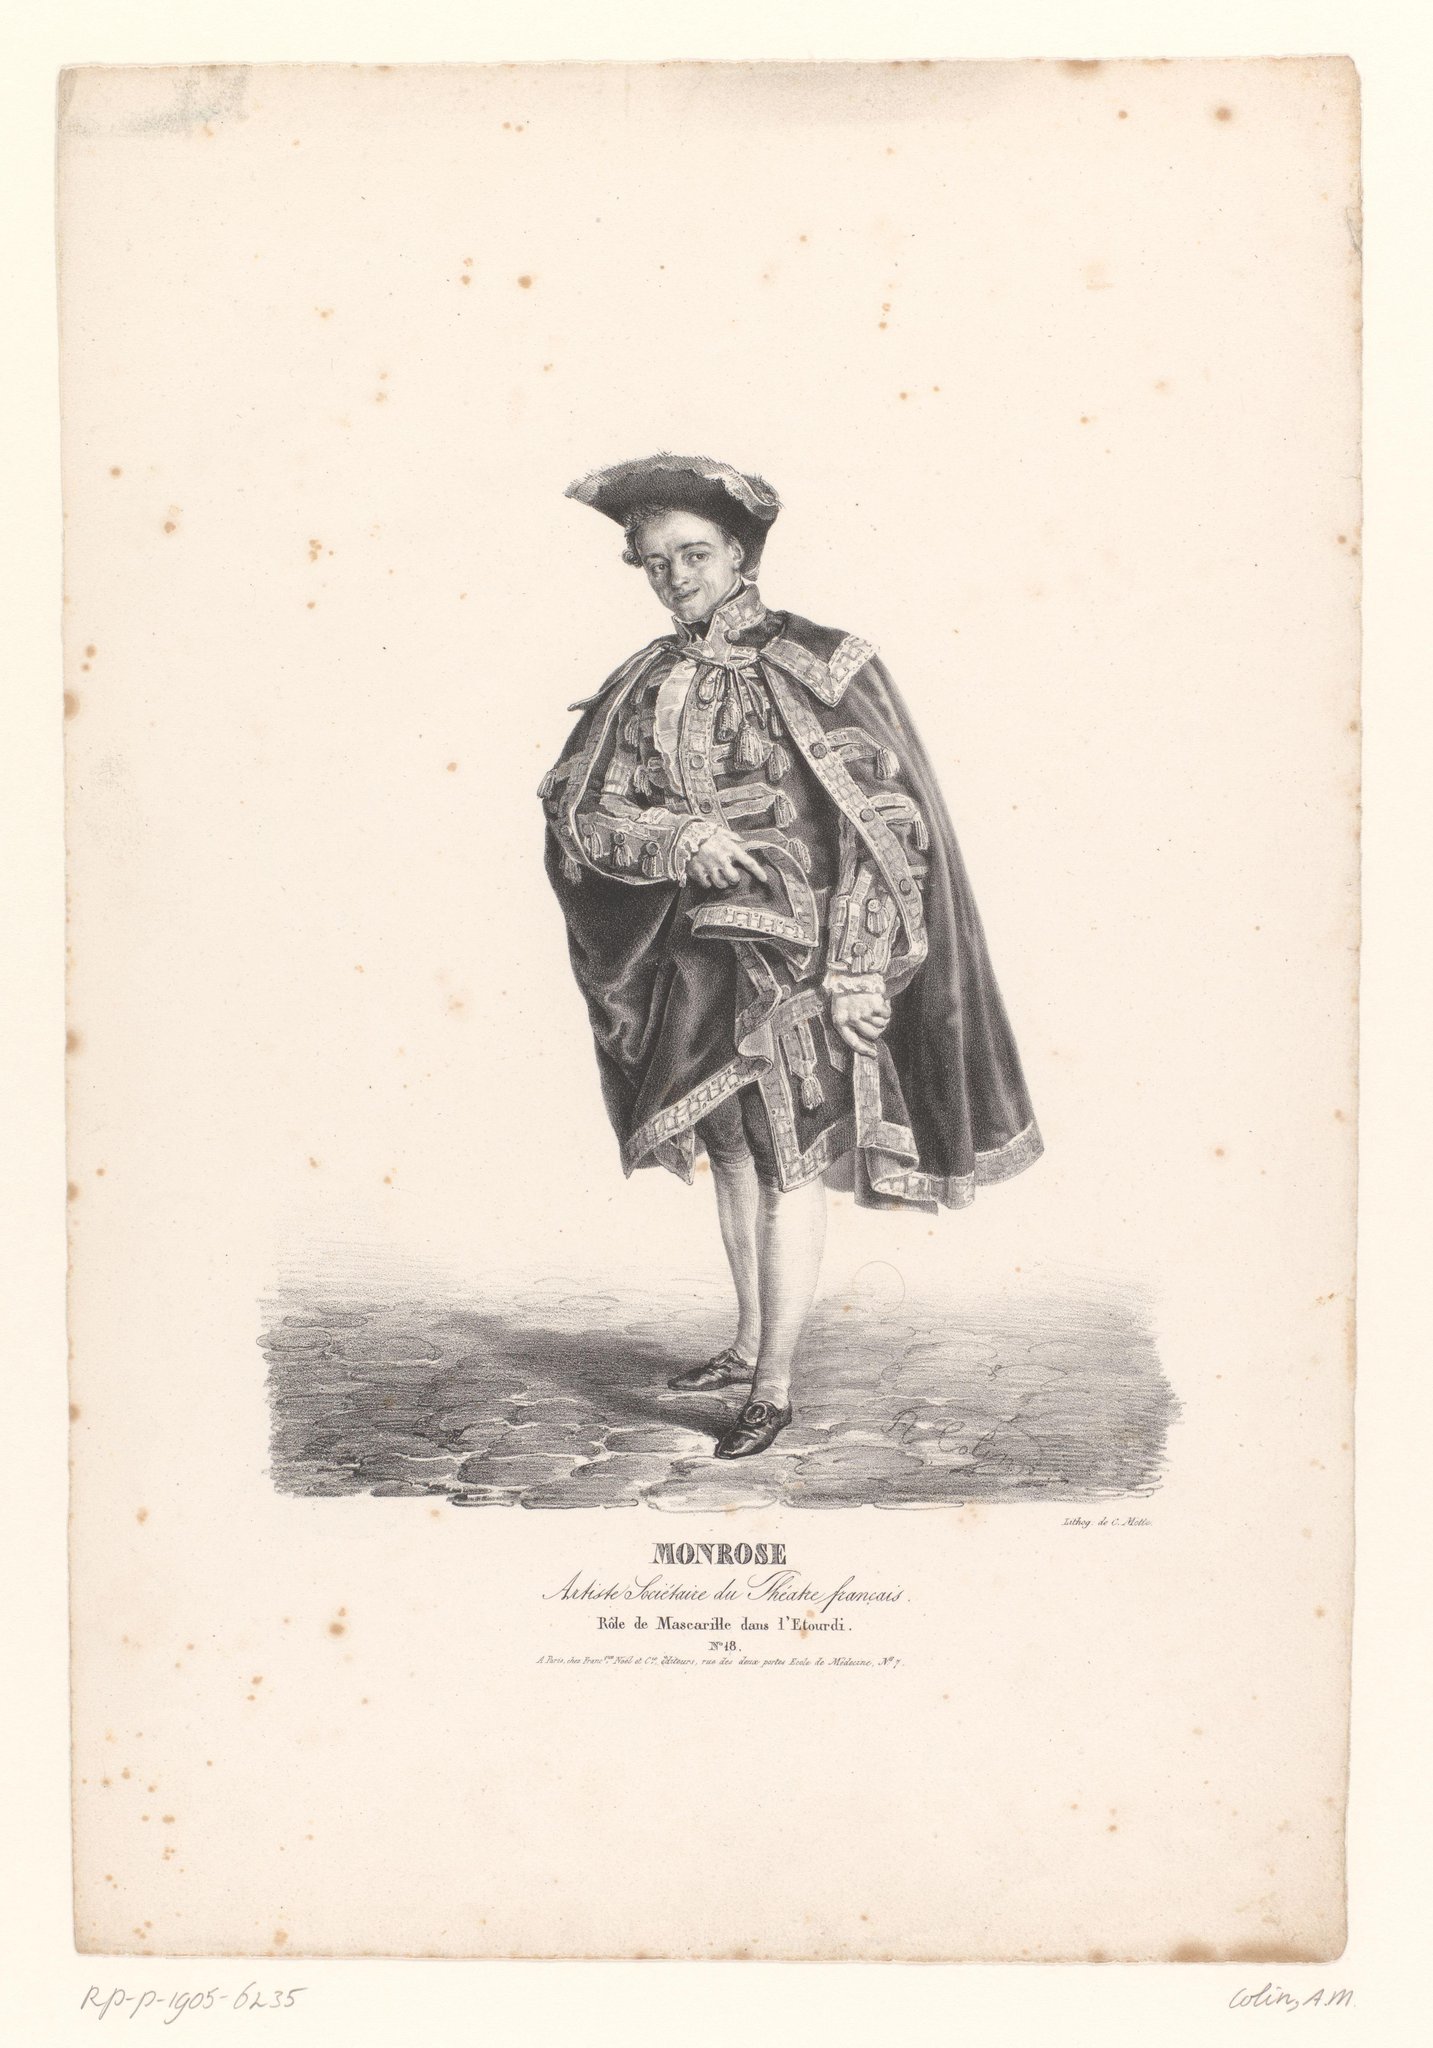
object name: print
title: Portretten van acteurs van Parijse theaters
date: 1823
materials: paper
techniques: lithograph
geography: paris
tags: stage costume, portrait of actor, actress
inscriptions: collector's mark: Lugt 2228a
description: Mascarille is een personage uit de komedie 'L'Étourdi' of 'Les Contretemps', geschreven door Molière in 1655. Opgevoerd door het Théâtre Français in Parijs in 1823.